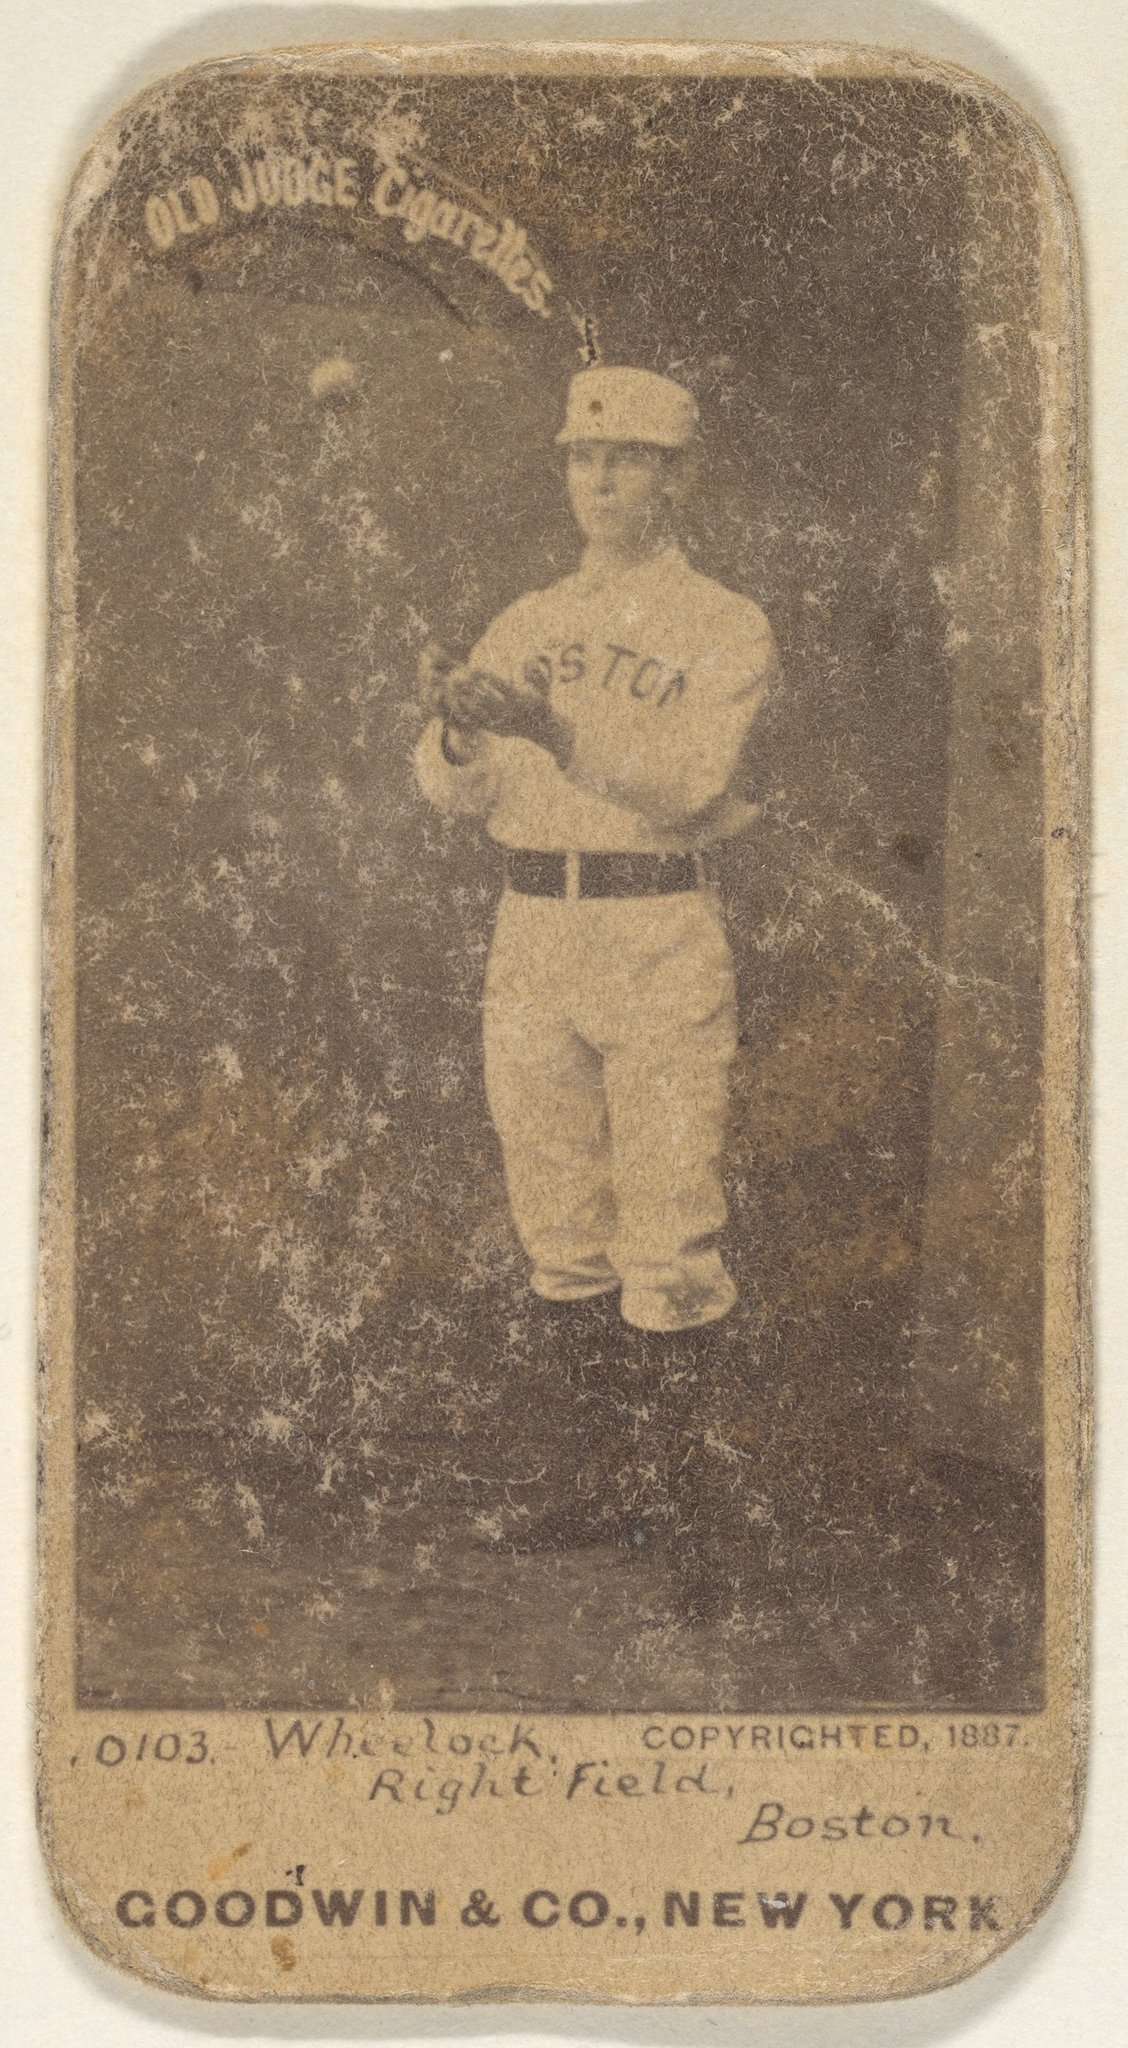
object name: baseball card, photograph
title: Wheelock, Right Field, Boston, from the Old Judge series (N172) for Old Judge Cigarettes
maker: goodwin & company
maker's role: publisher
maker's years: 1850-1950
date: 1887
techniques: albumen silver print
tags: men,portraits,baseball,athletes